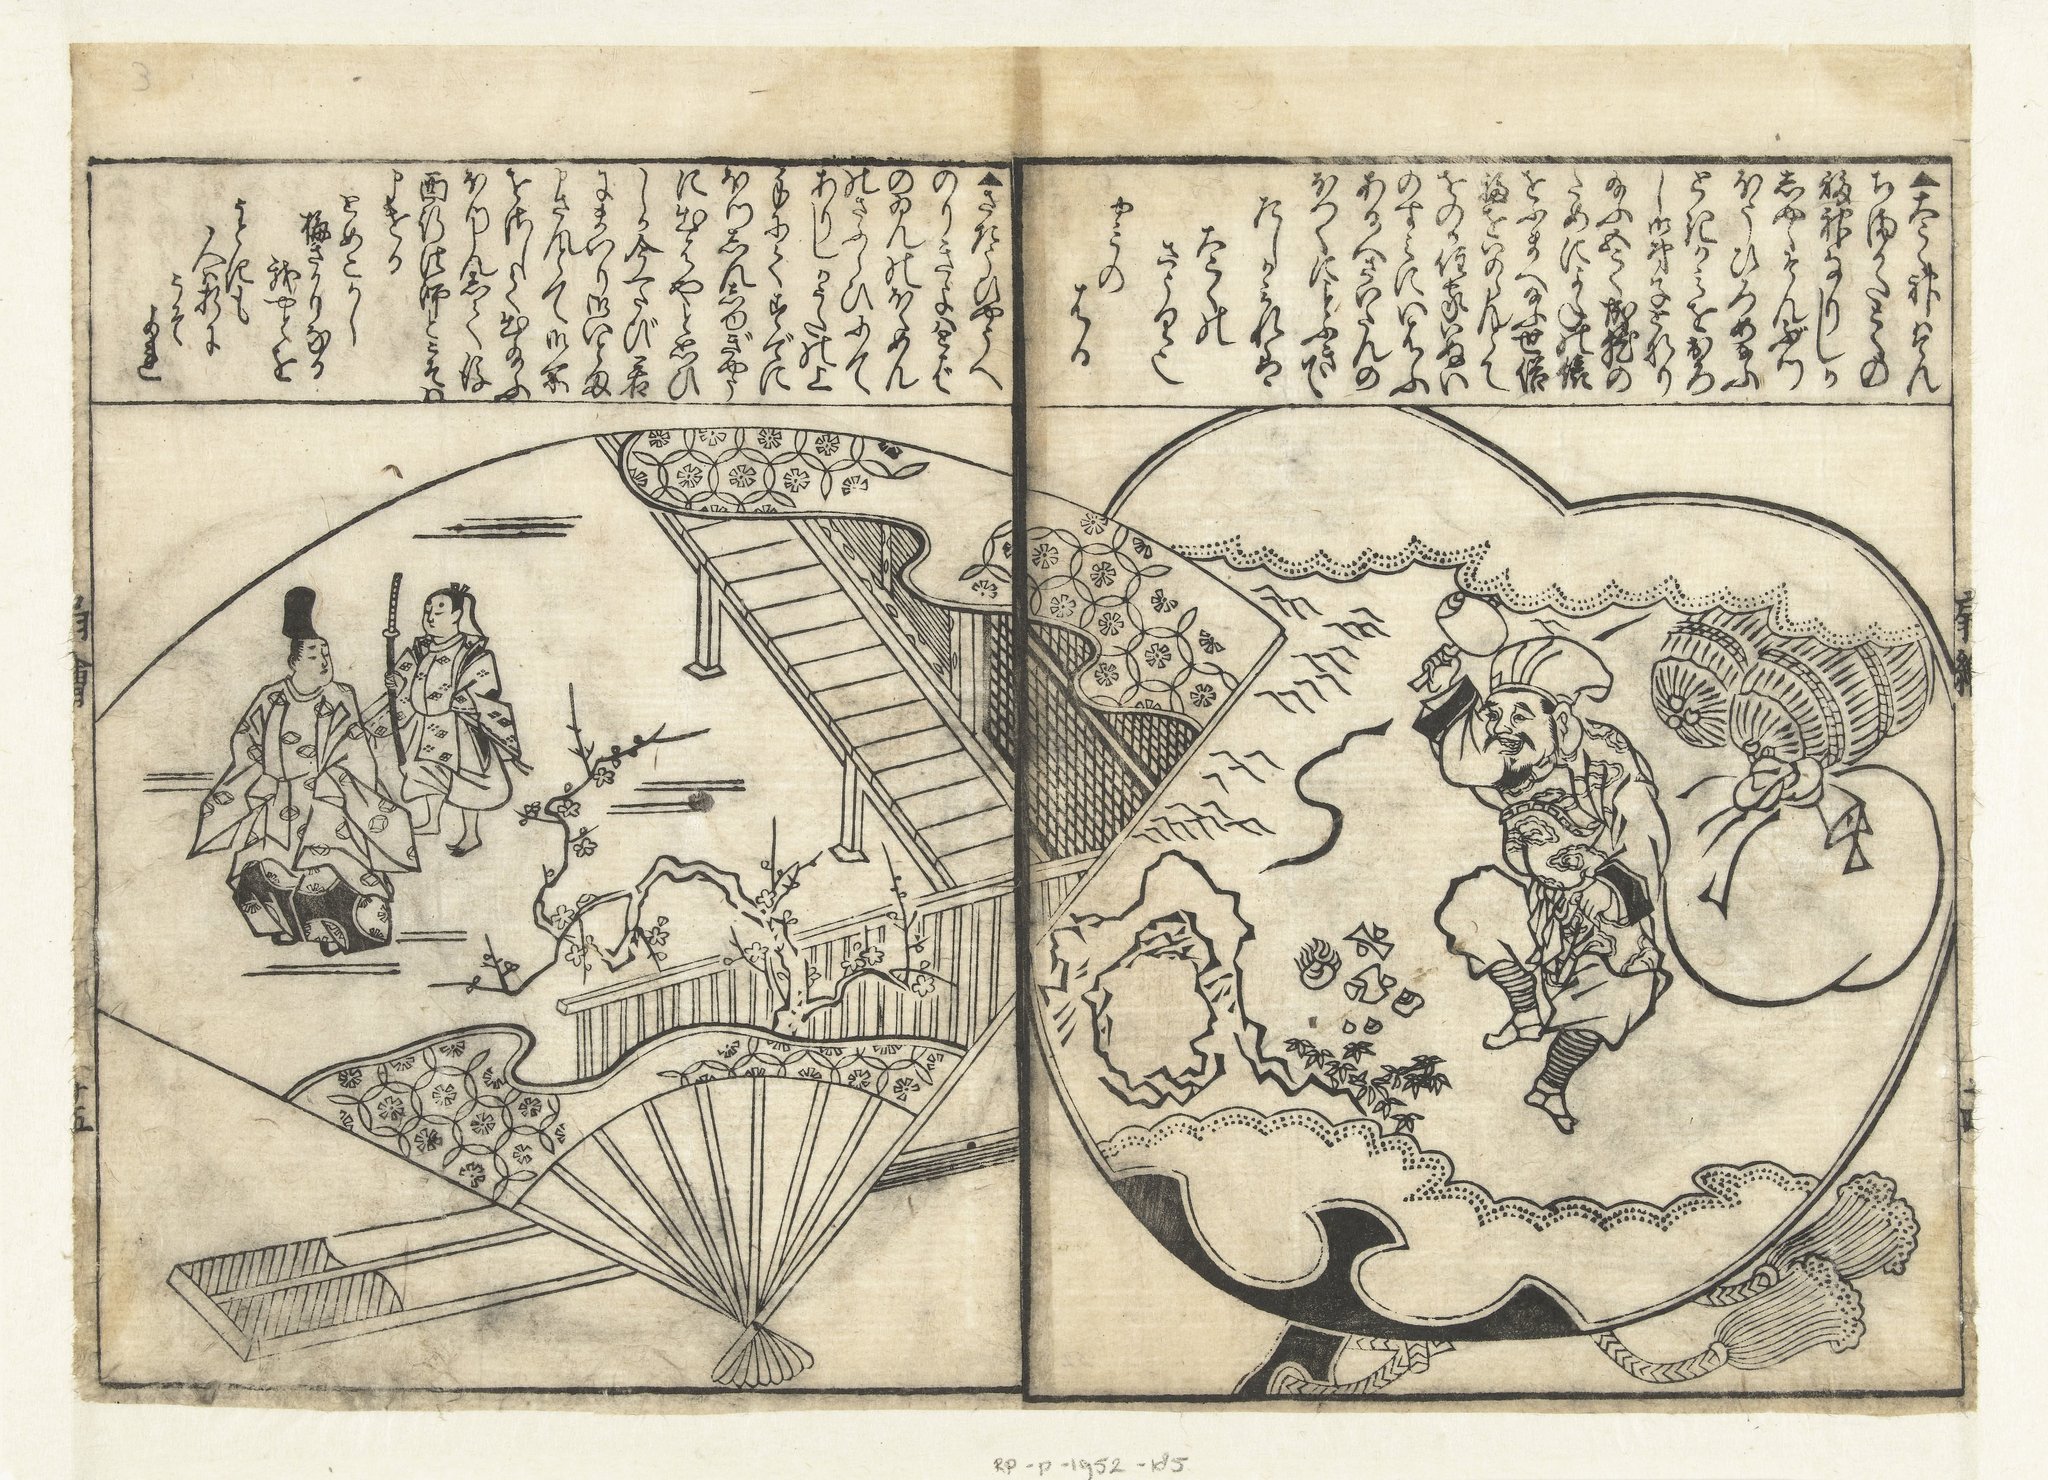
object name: print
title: Twee waaiers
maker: tachibana morikuni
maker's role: print maker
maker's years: 1679-1748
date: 1700-1750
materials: paper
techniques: woodcut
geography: japan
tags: fan, man dancing alone, house personnel, servants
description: Pagina 14 (rechts) en 15 (links) van een Japans boek, met twee waaiers waarboven tekst. Links, een waaier waarop een hoveling en lakei, lopend in een tuin met een veranda en bloesemende pruimenboom. Rechts, een waaier waarop een dansende man op een strand.